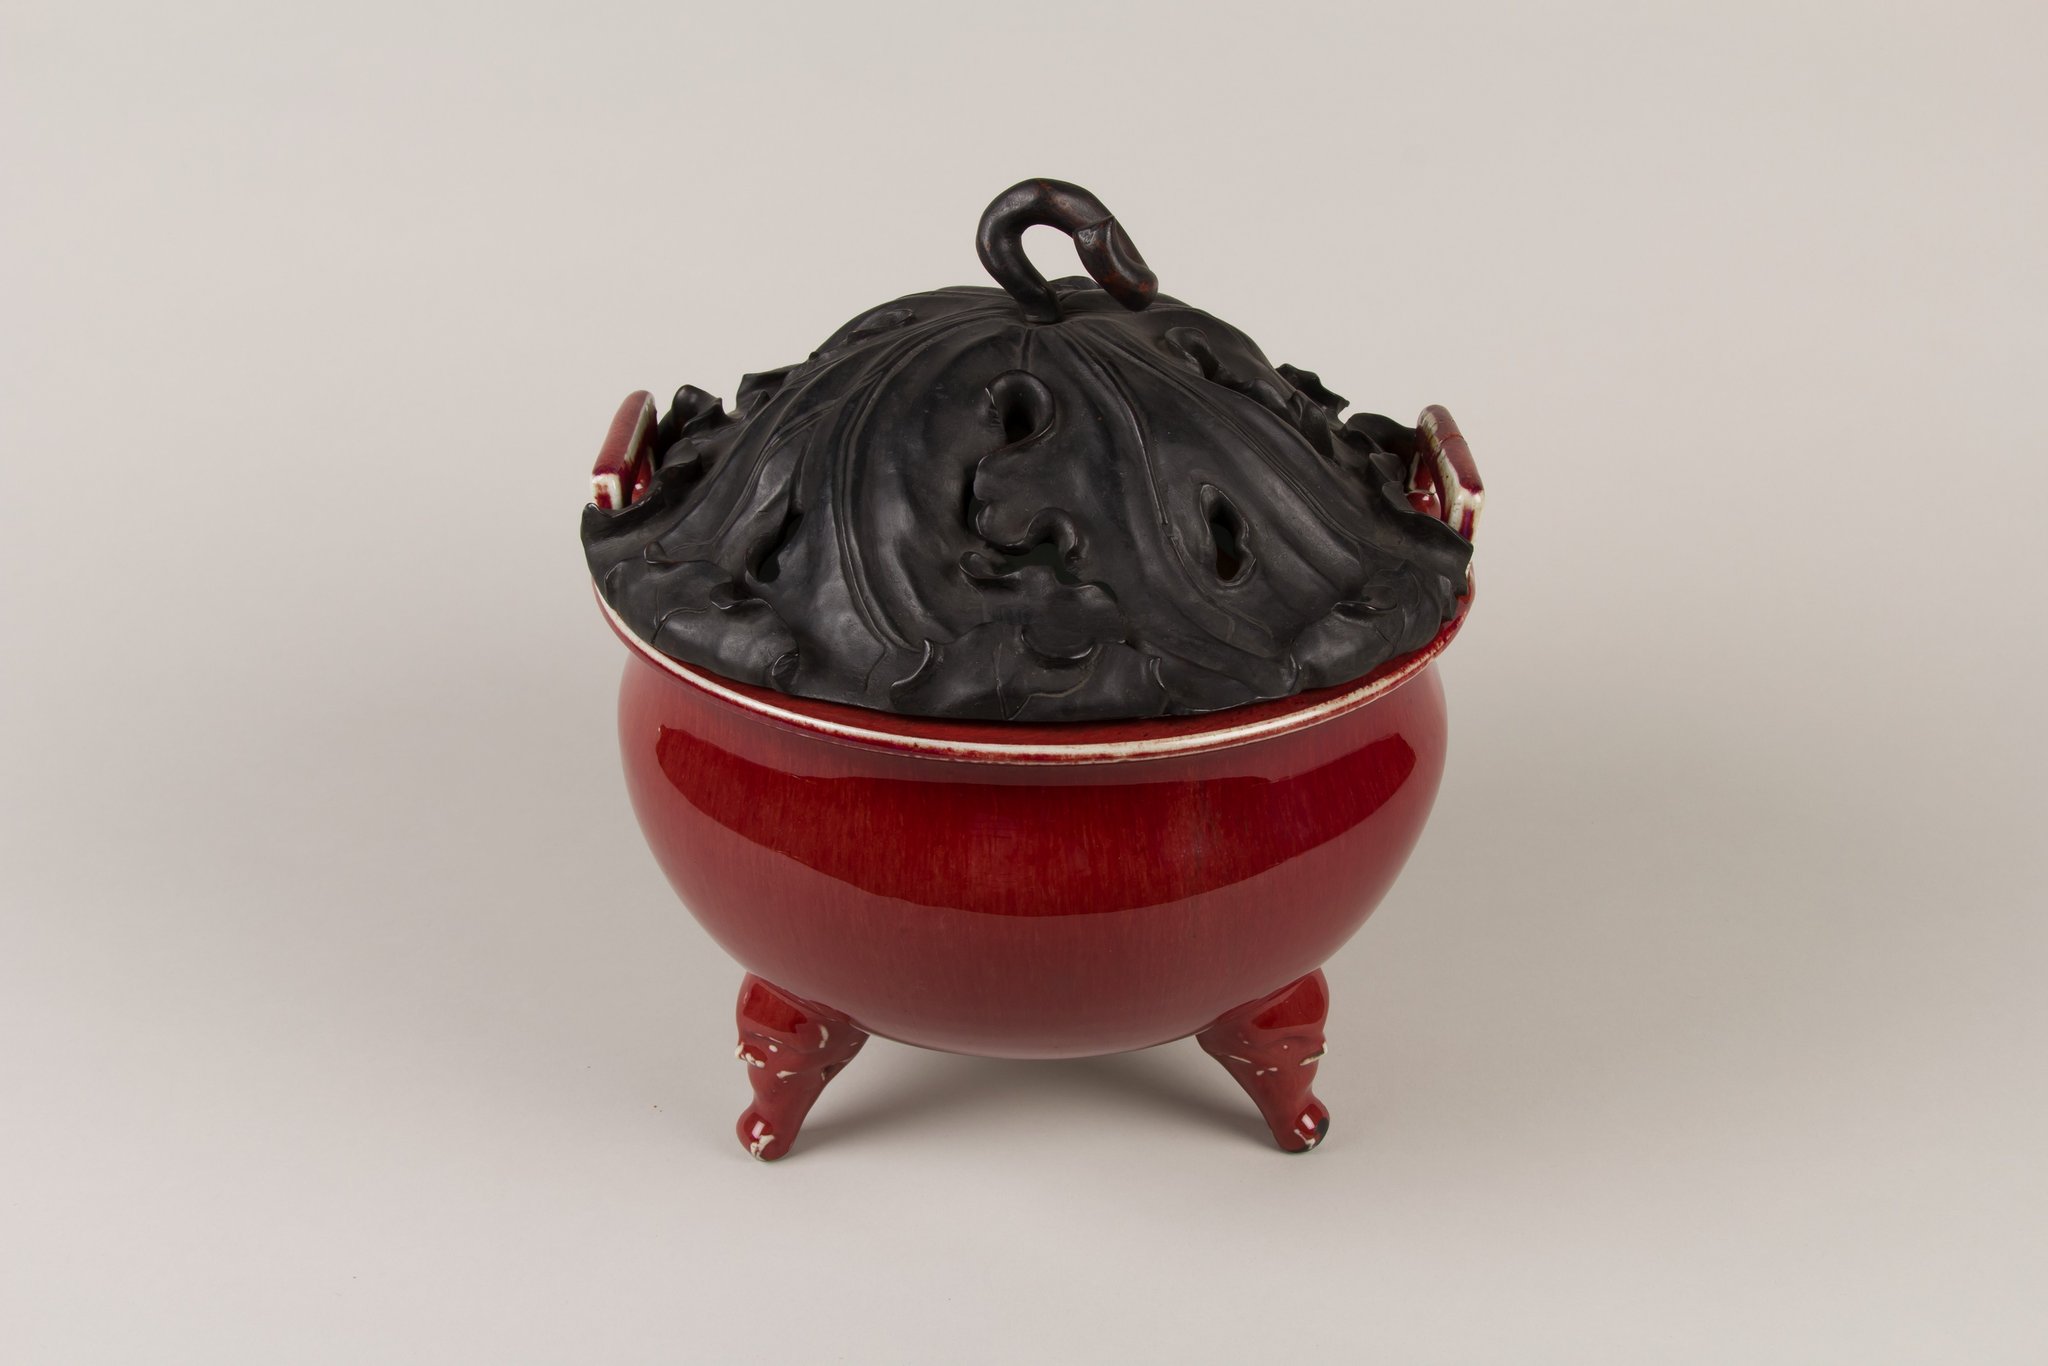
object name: incense burner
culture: chinese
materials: glaze, porcelain